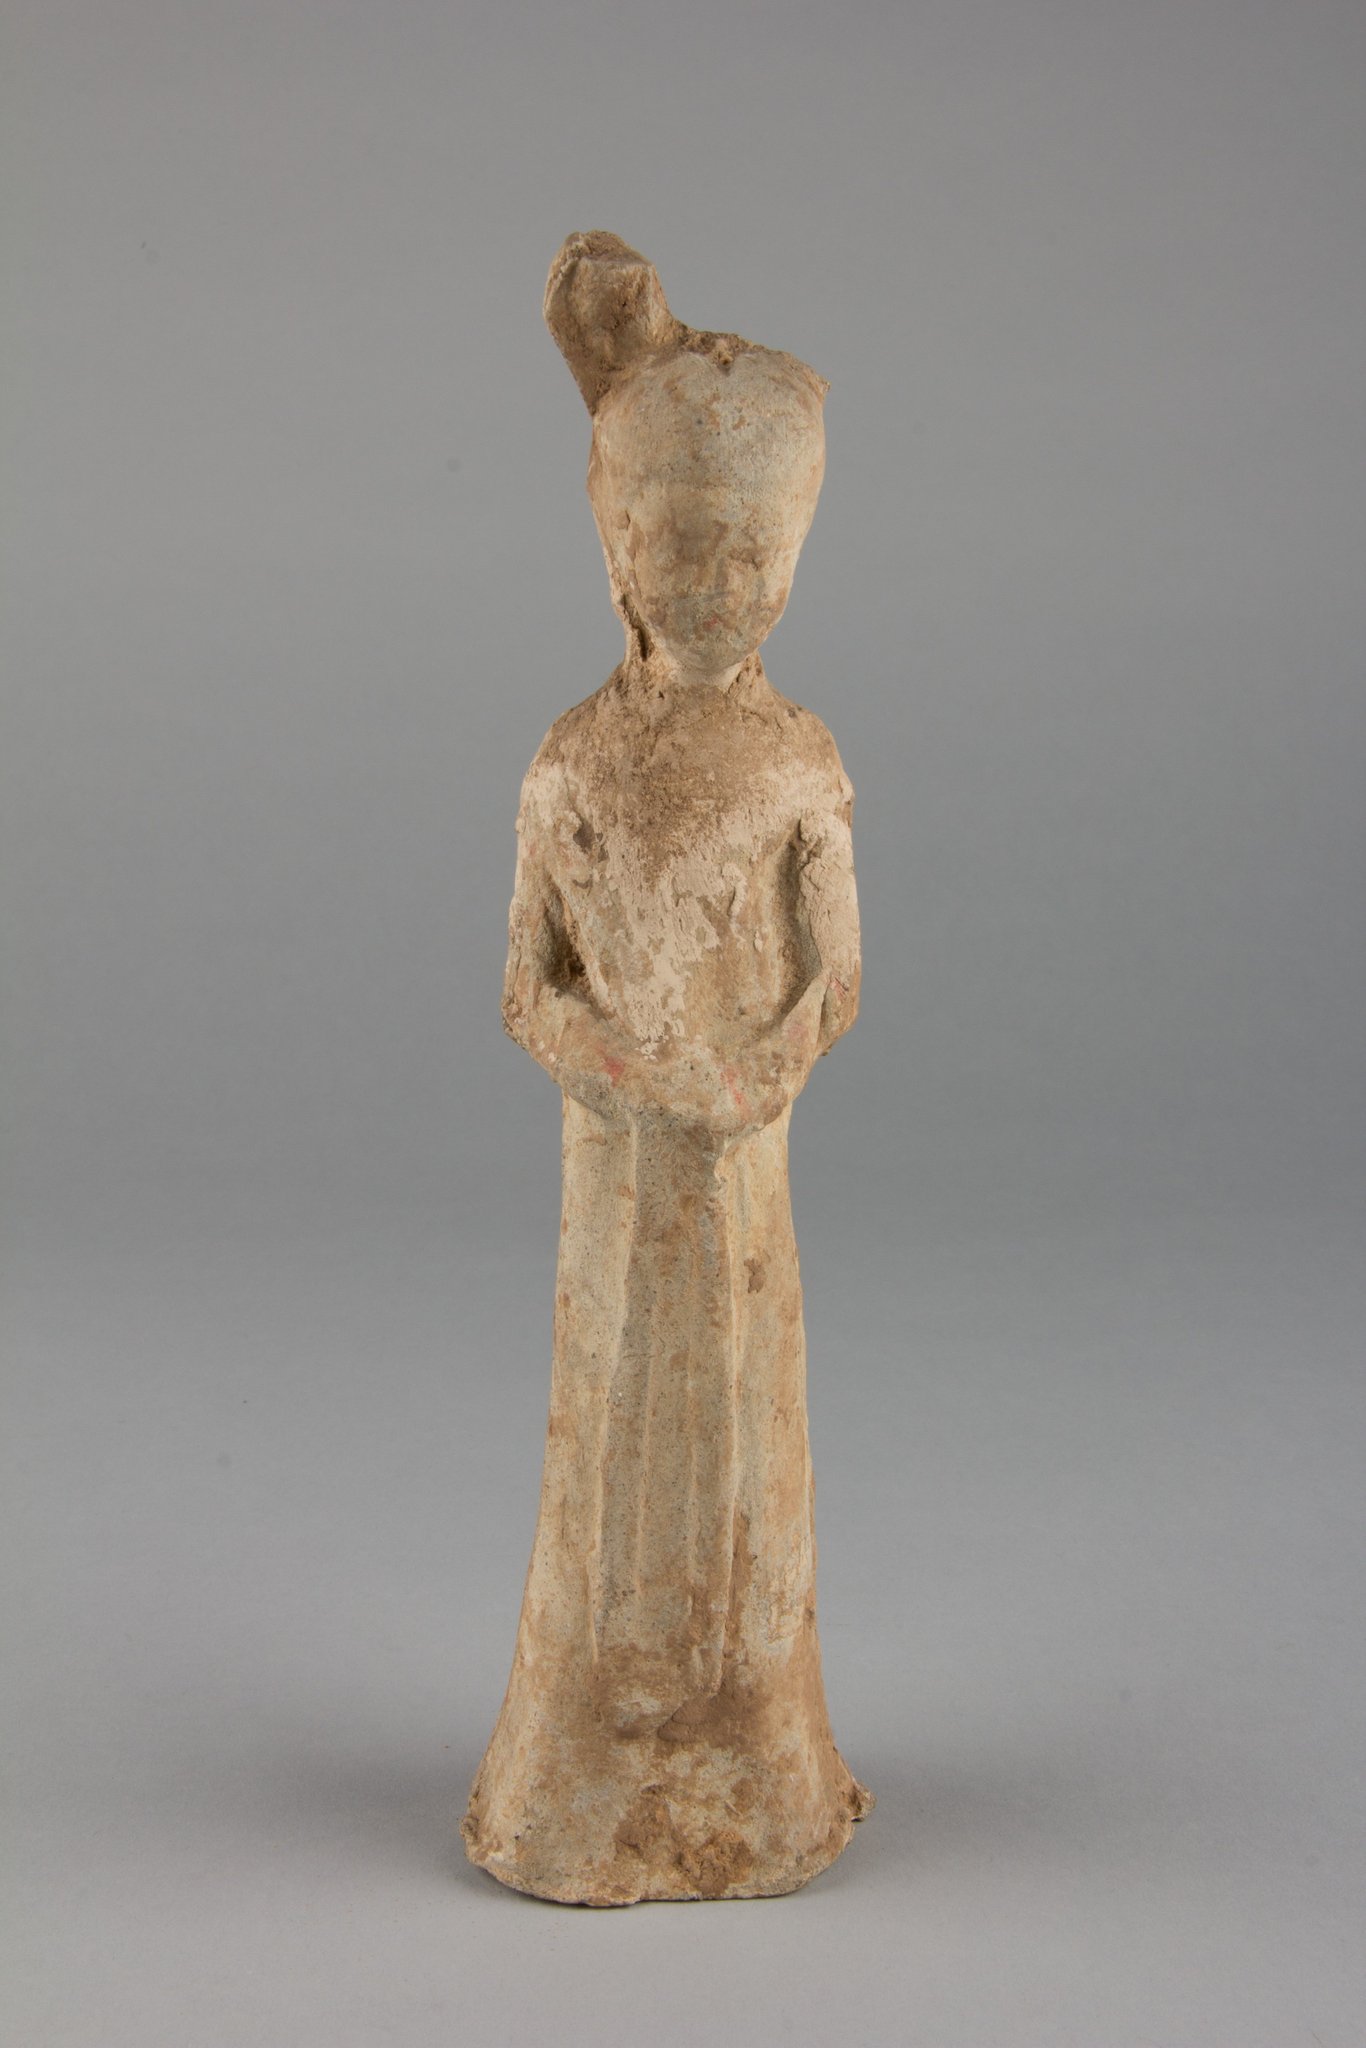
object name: figure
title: Figure of a standing woman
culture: chinese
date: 601-800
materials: earthenware, pigment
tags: women